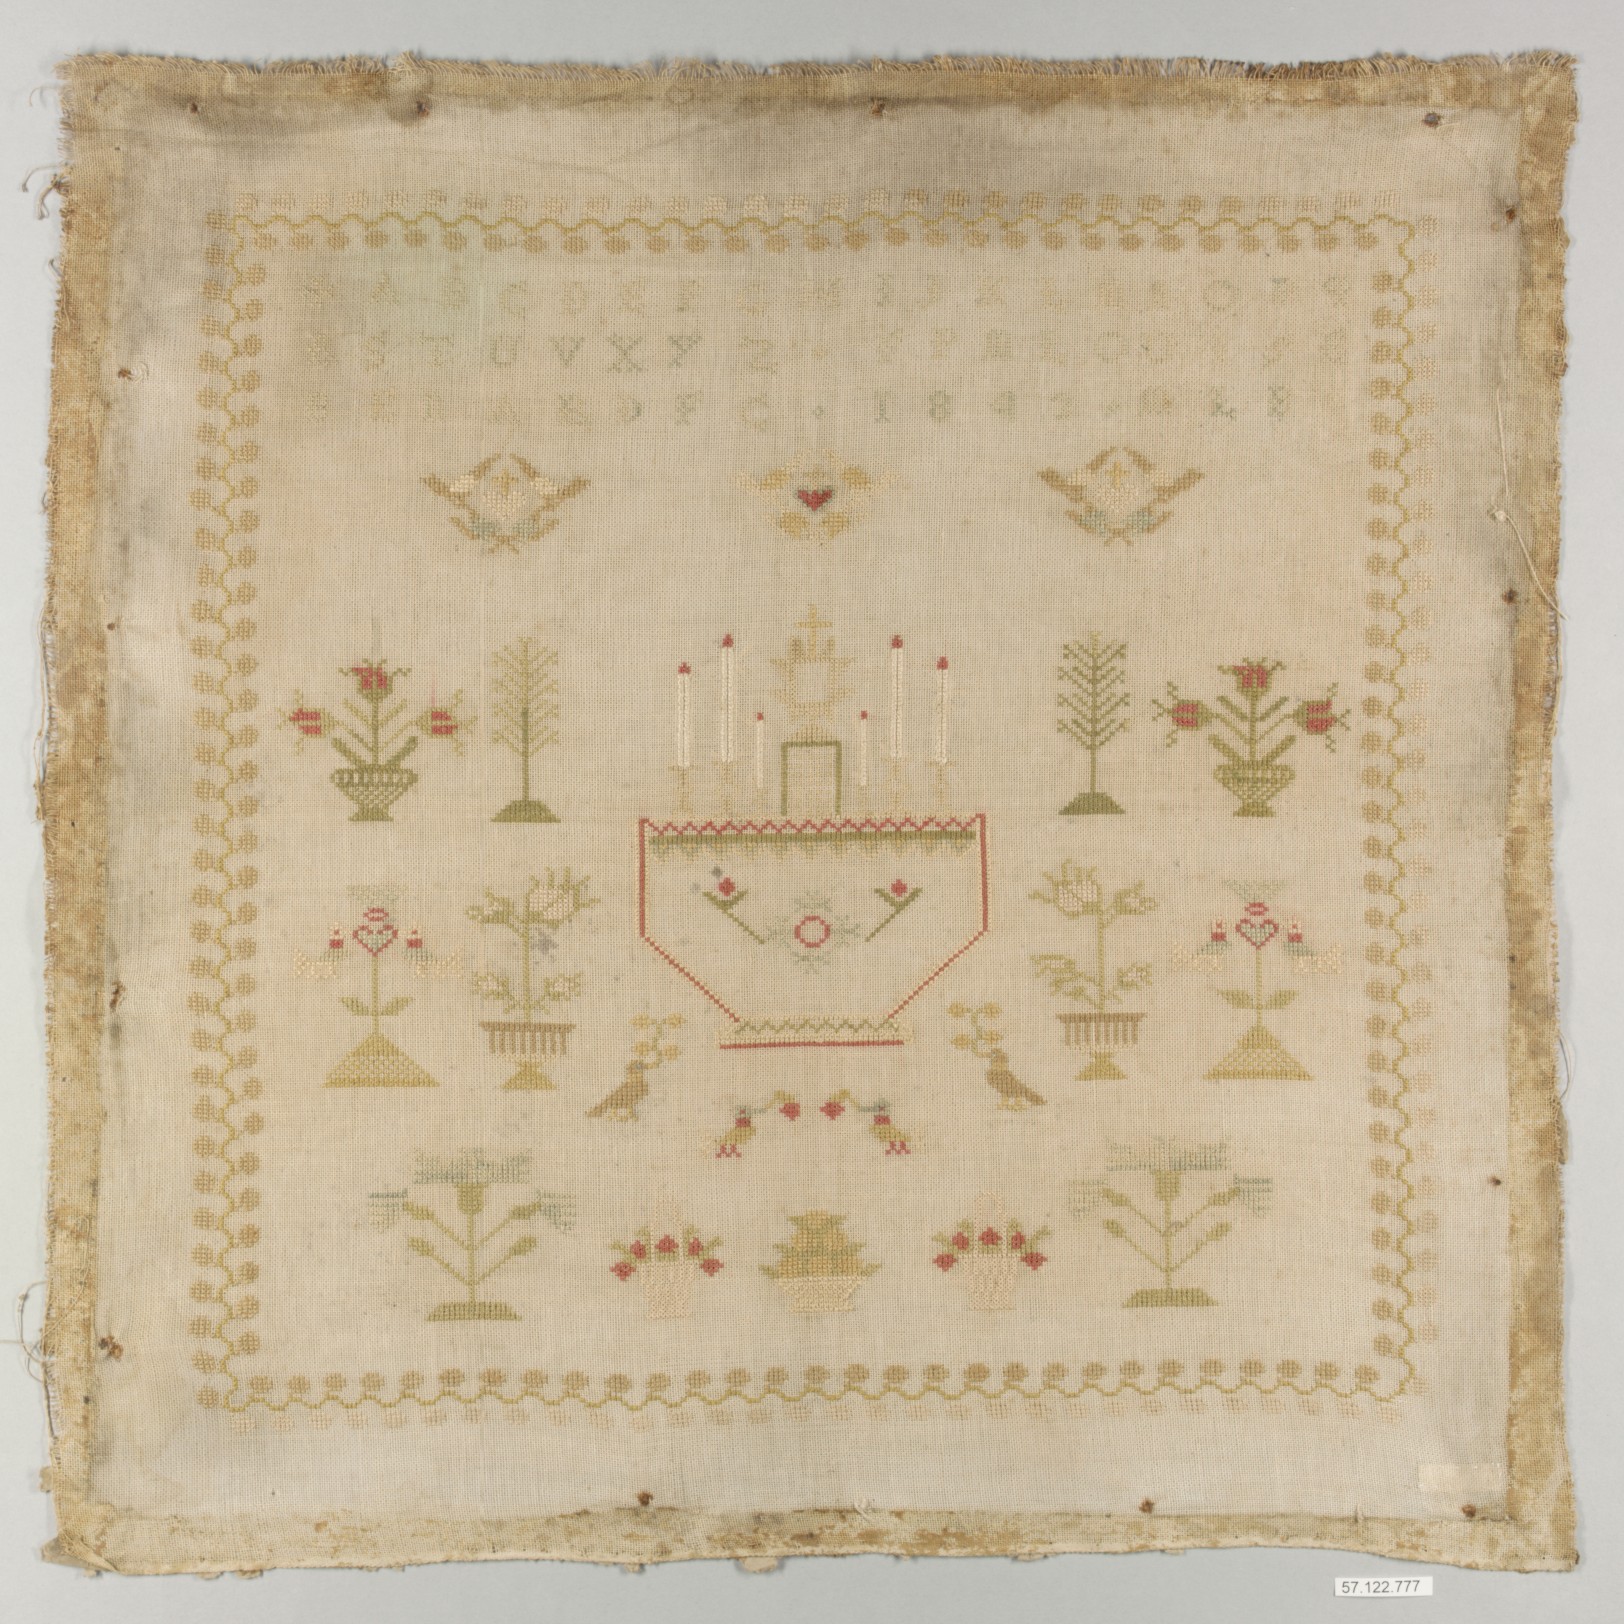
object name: sampler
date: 1843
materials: canvas, silk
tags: flowers